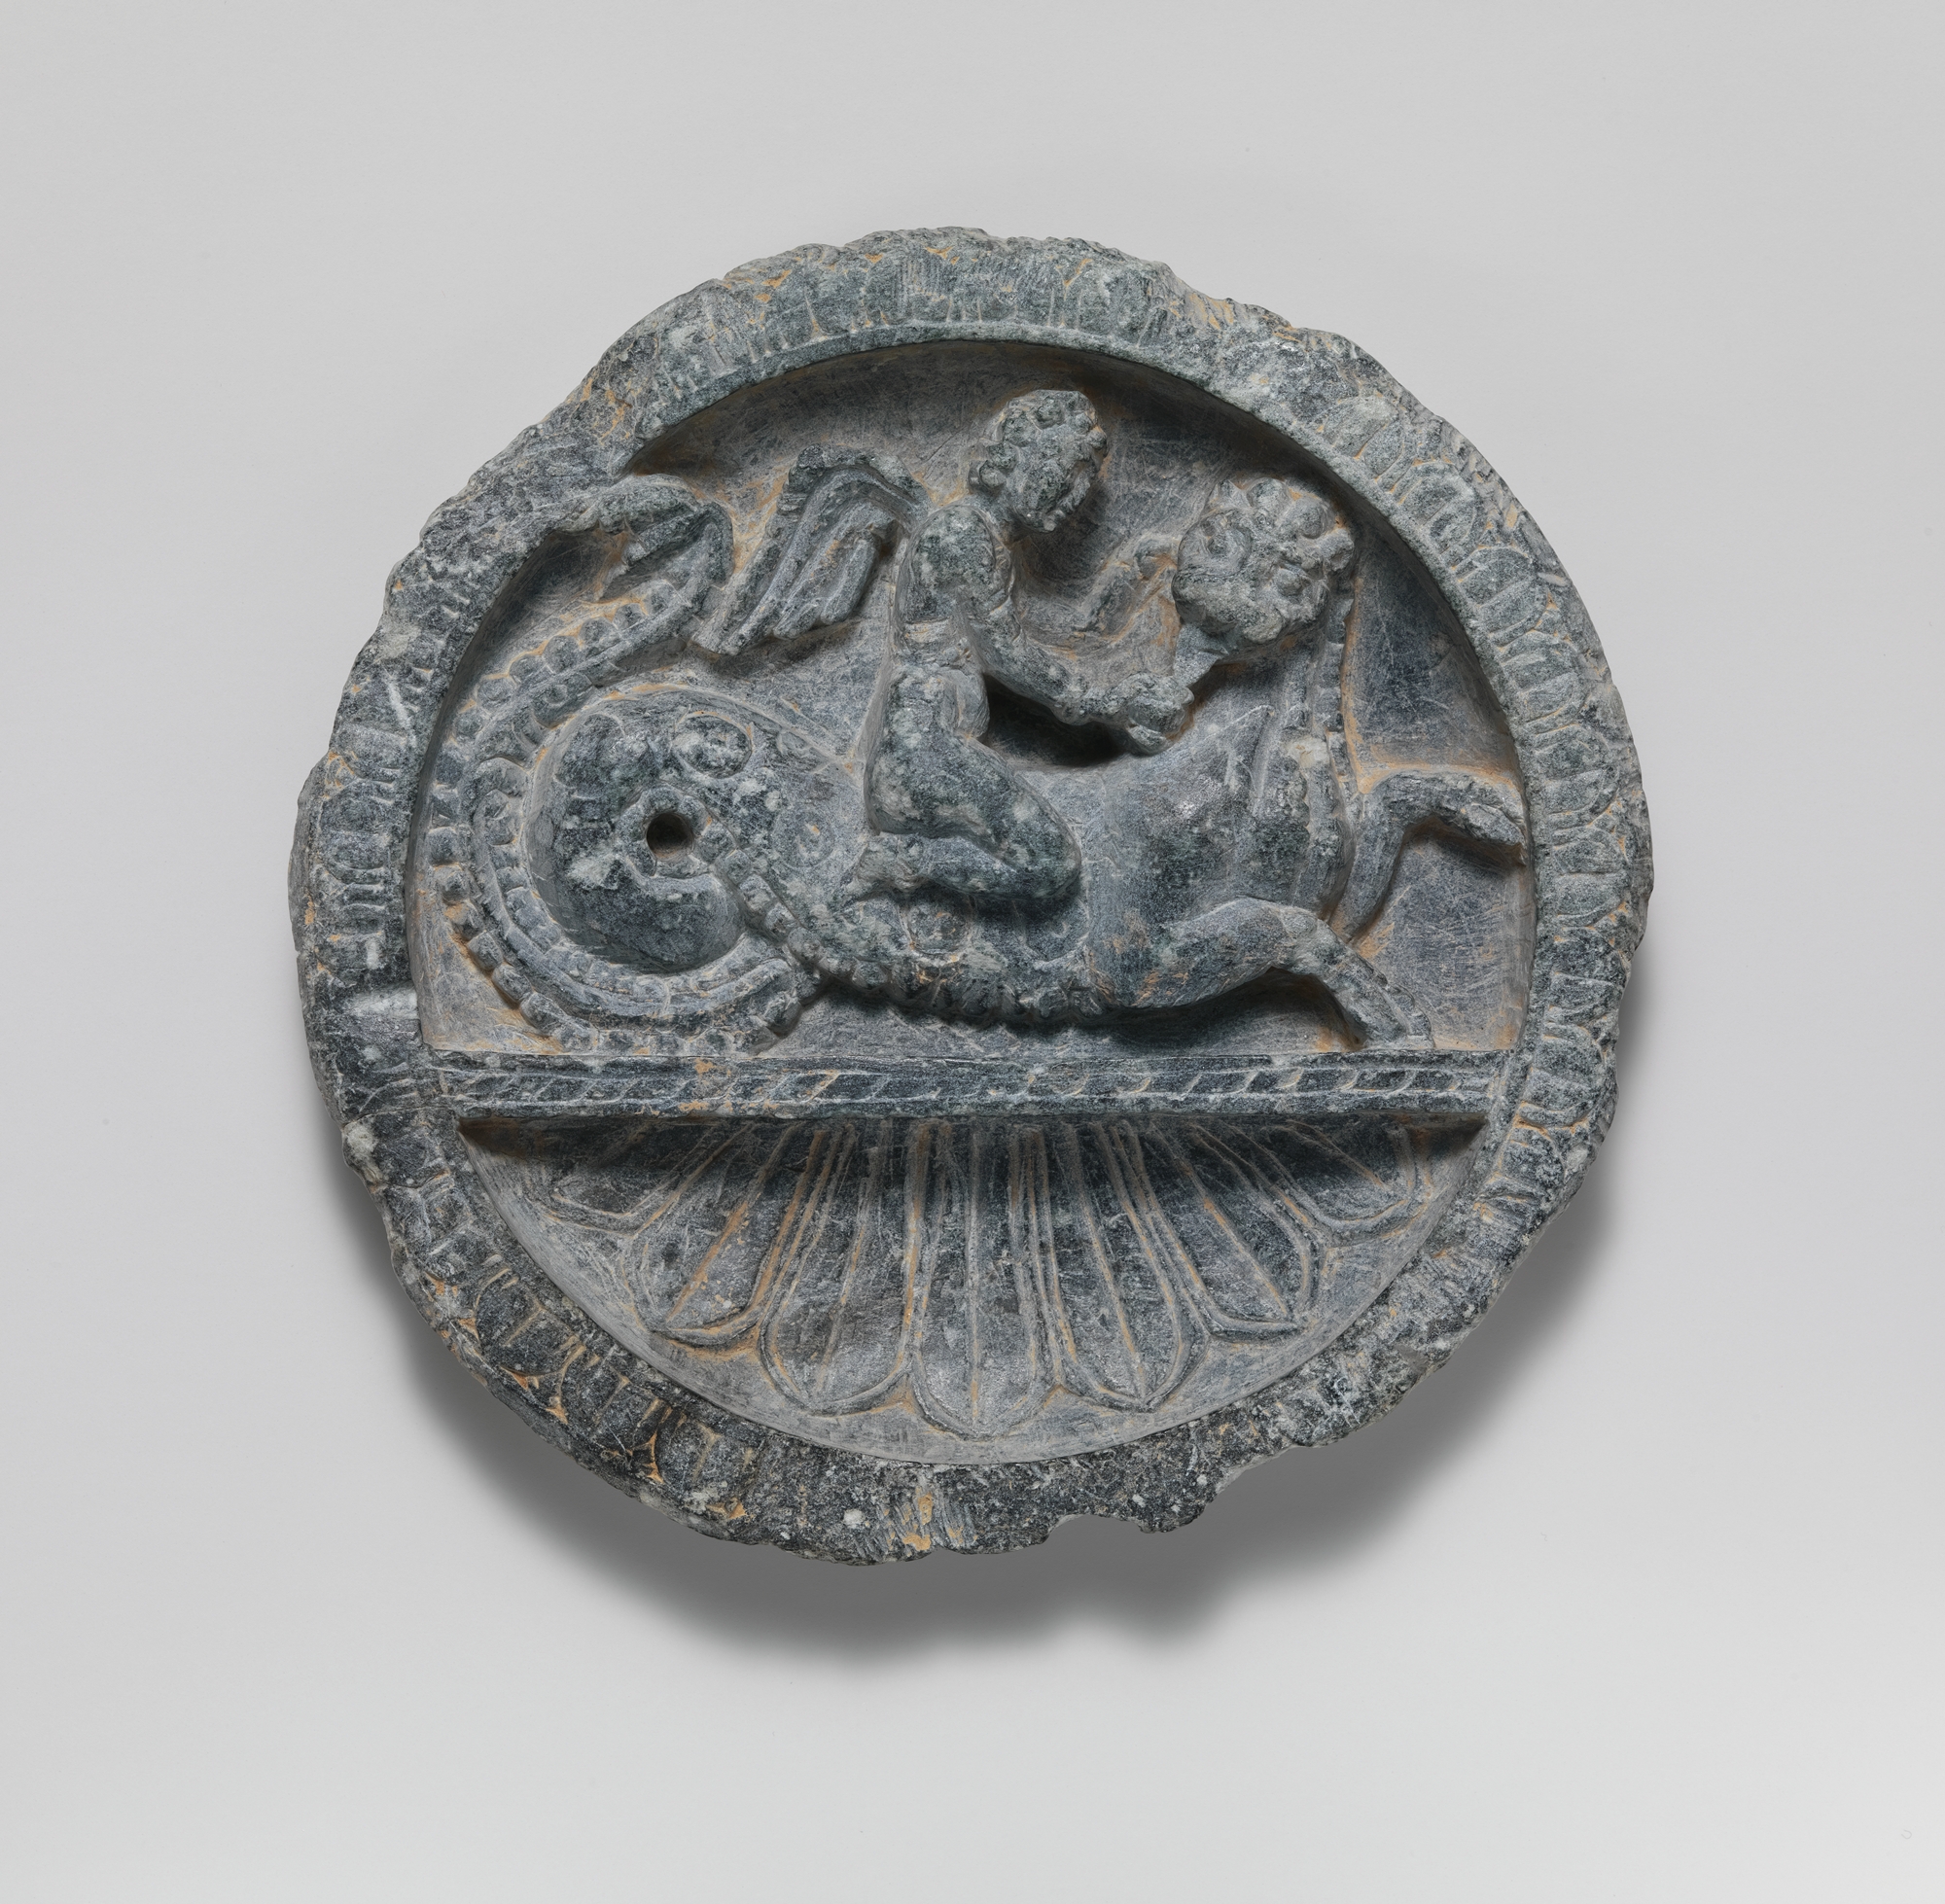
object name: dish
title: Dish with Winged Eros Riding a Lion-Headed Sea Monster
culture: gandhara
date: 100-1 BCE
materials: stone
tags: gandhara,eros,monsters